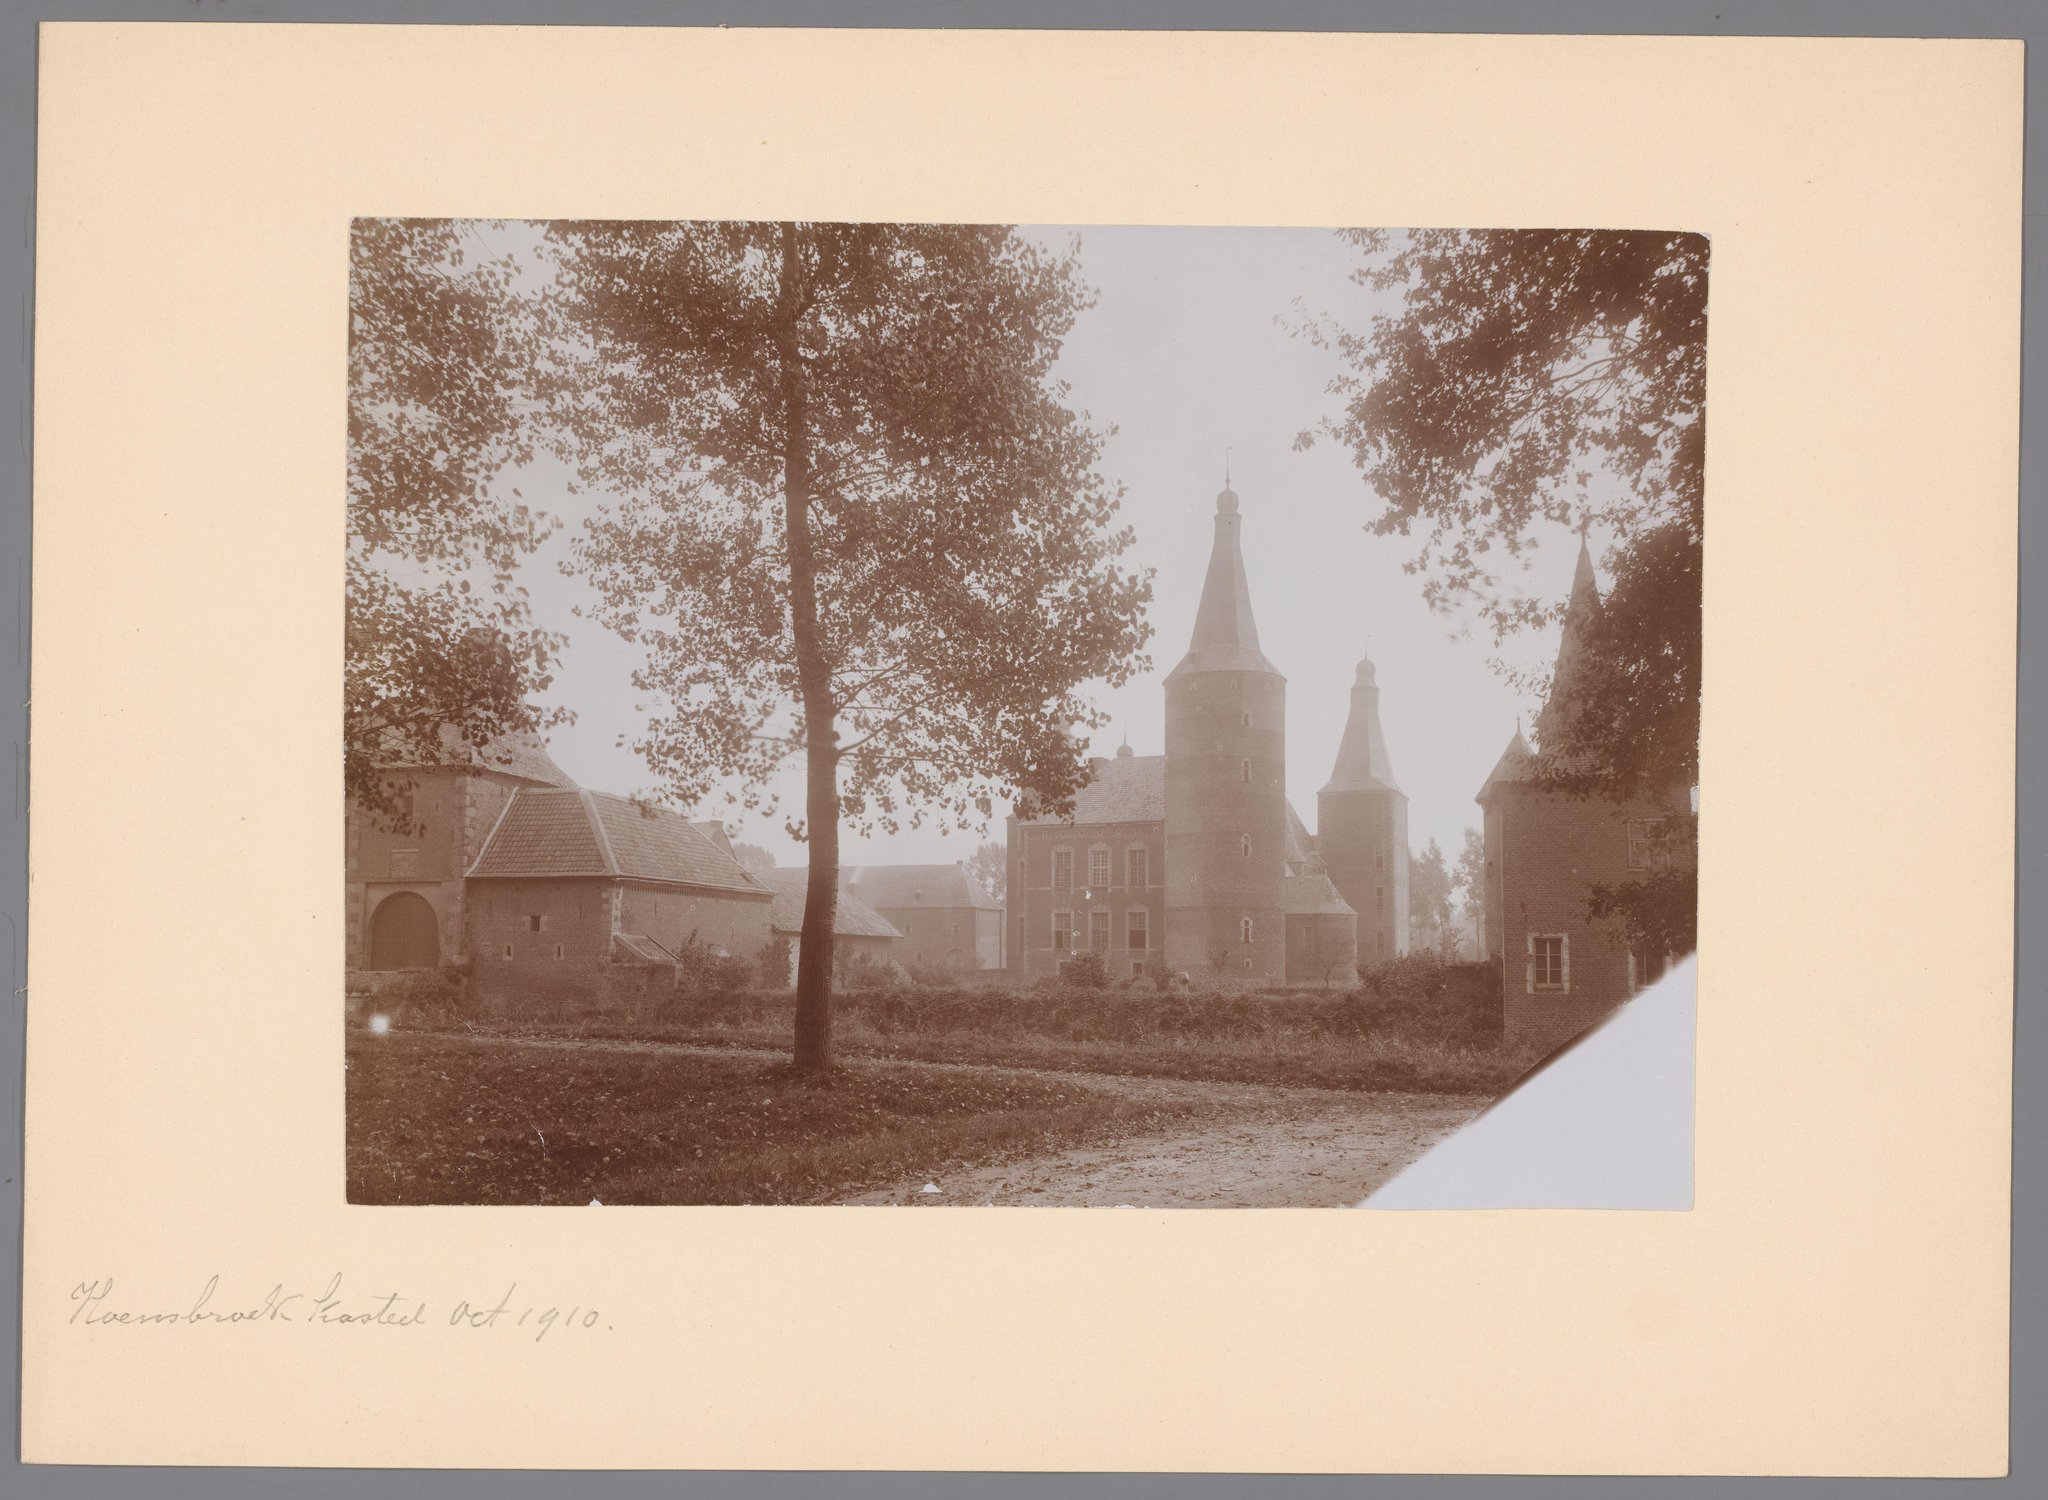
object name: photograph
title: Kasteel Hoensbroek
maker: anoniem (monumentenzorg)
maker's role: fotograaf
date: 1910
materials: cardboard, photographic support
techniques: collodion silver print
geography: hoensbroek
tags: castle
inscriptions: annotation: ‘Hoensbroek kasteel oct: 1910’